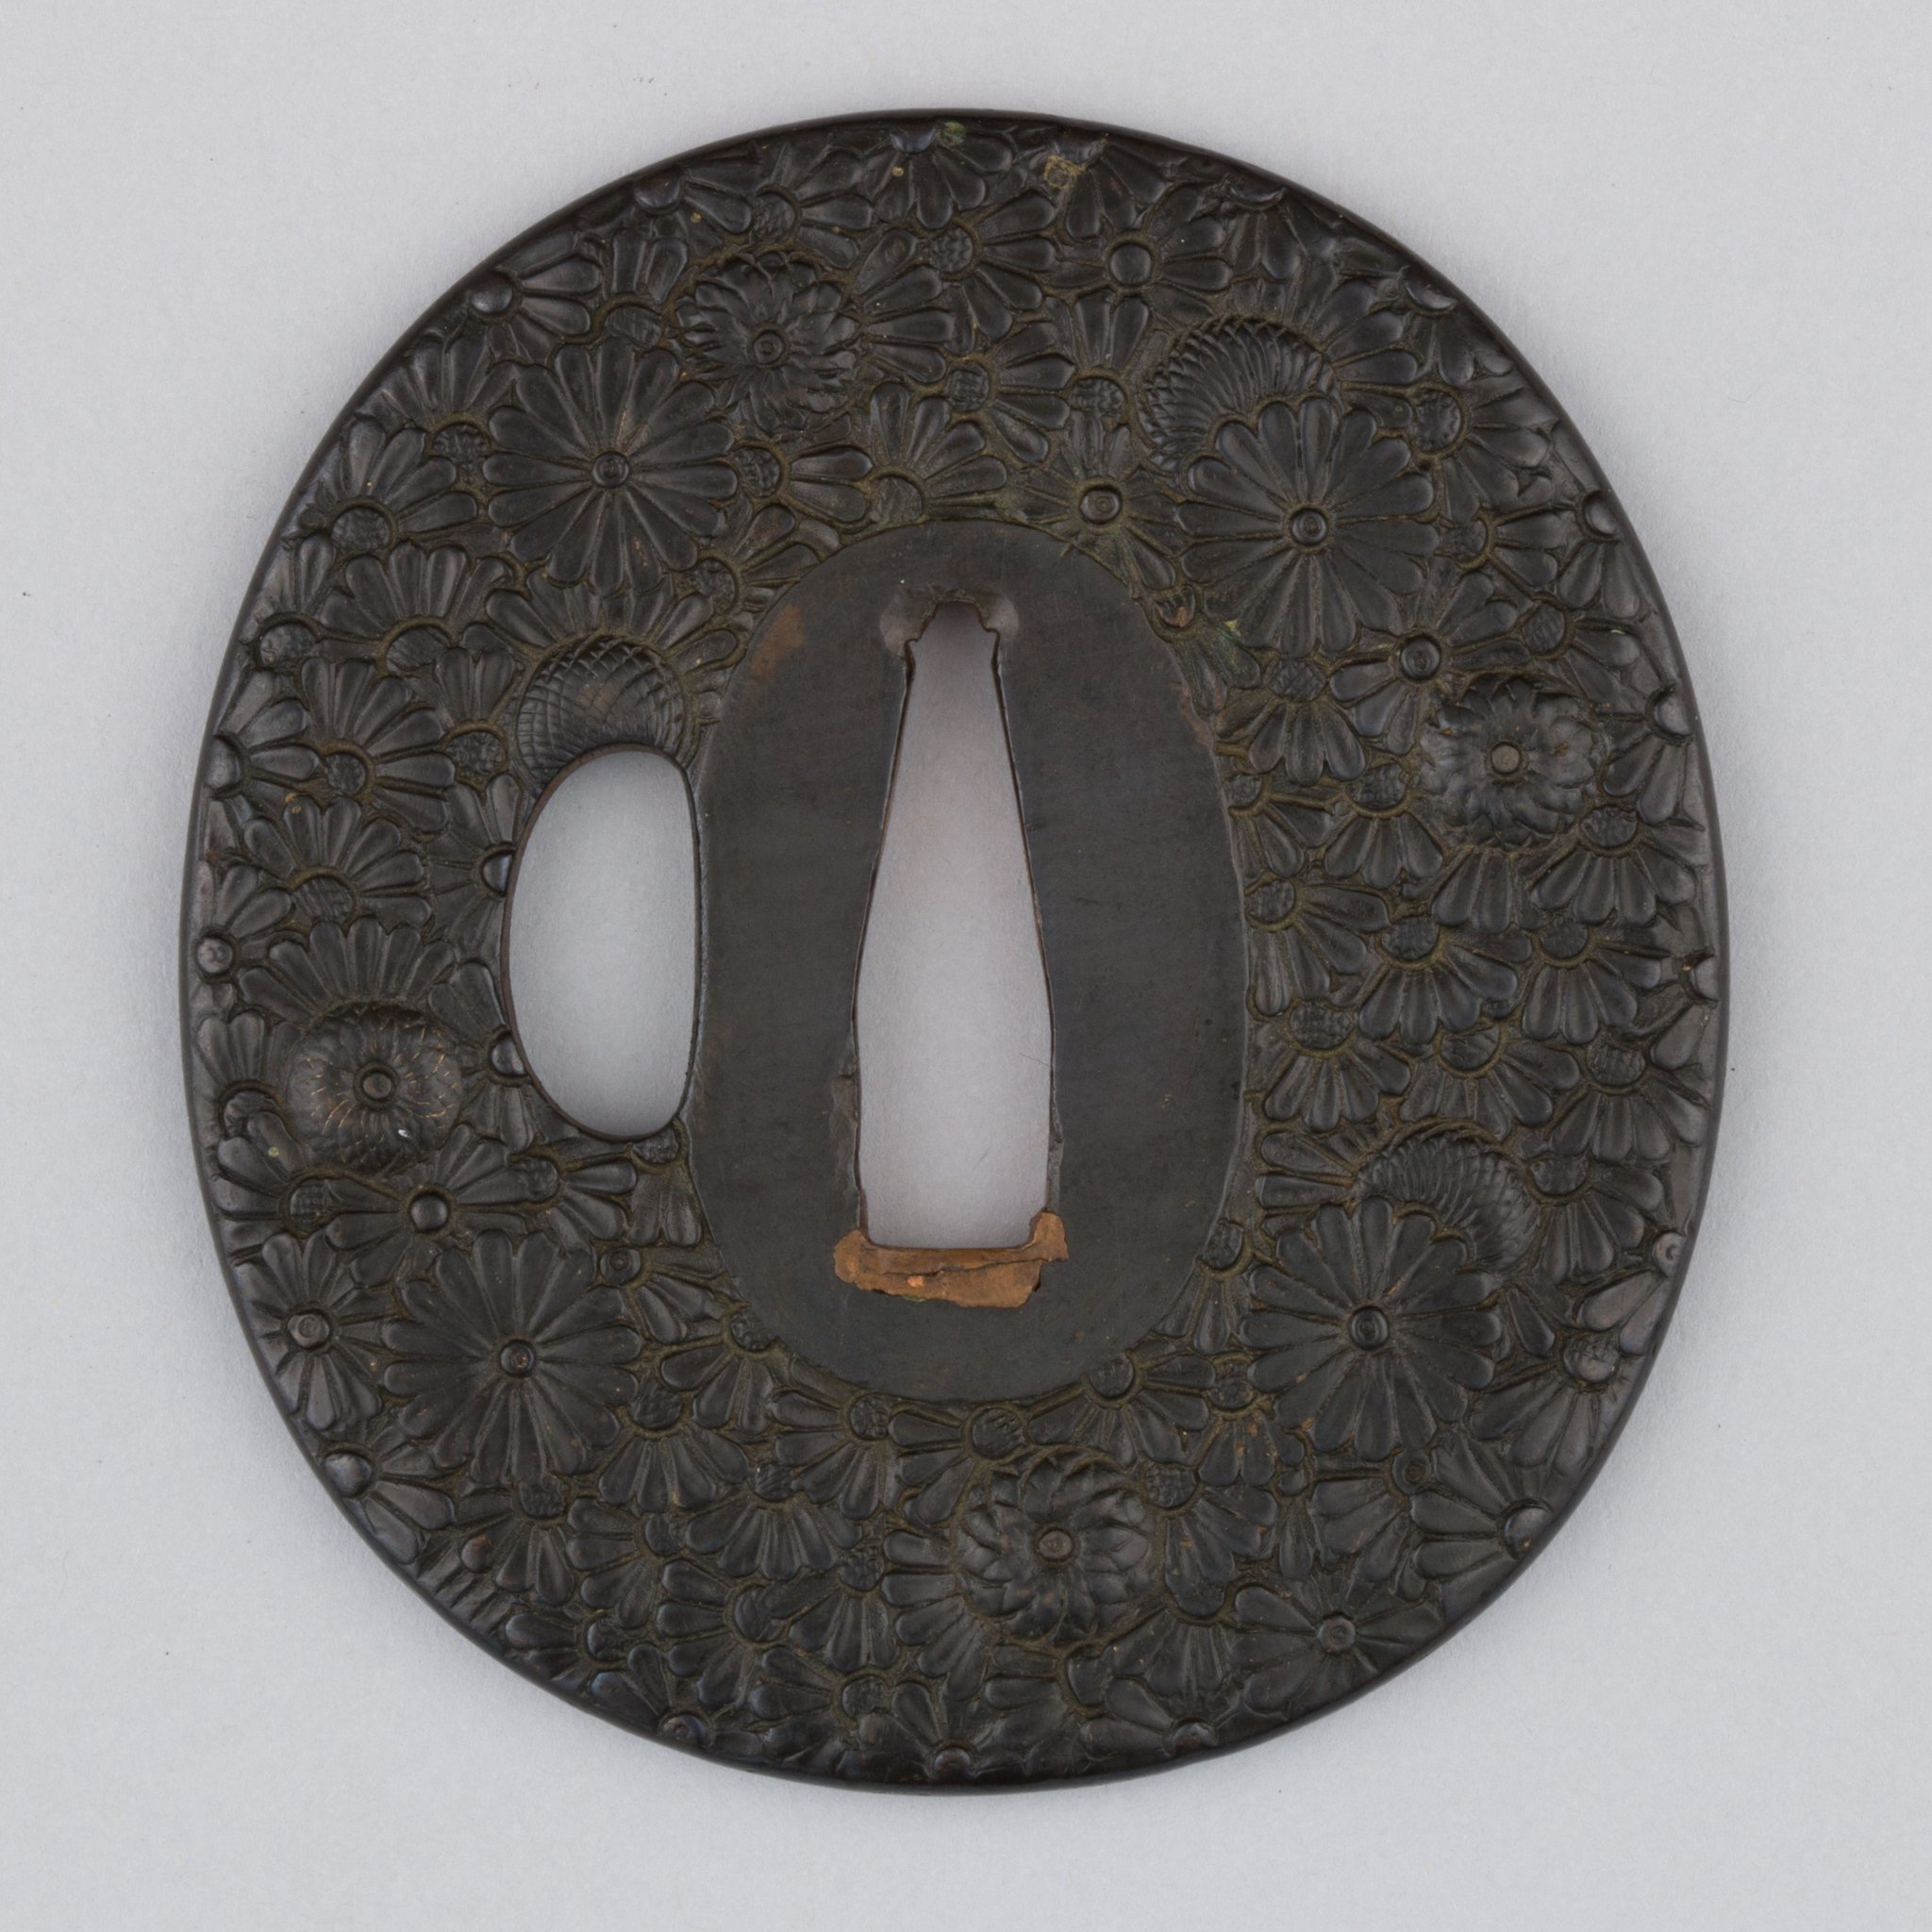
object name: sword guard tsuba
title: Sword Guard (Tsuba)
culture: japanese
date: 1615-1868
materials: copper, gold alloy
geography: japan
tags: flowers